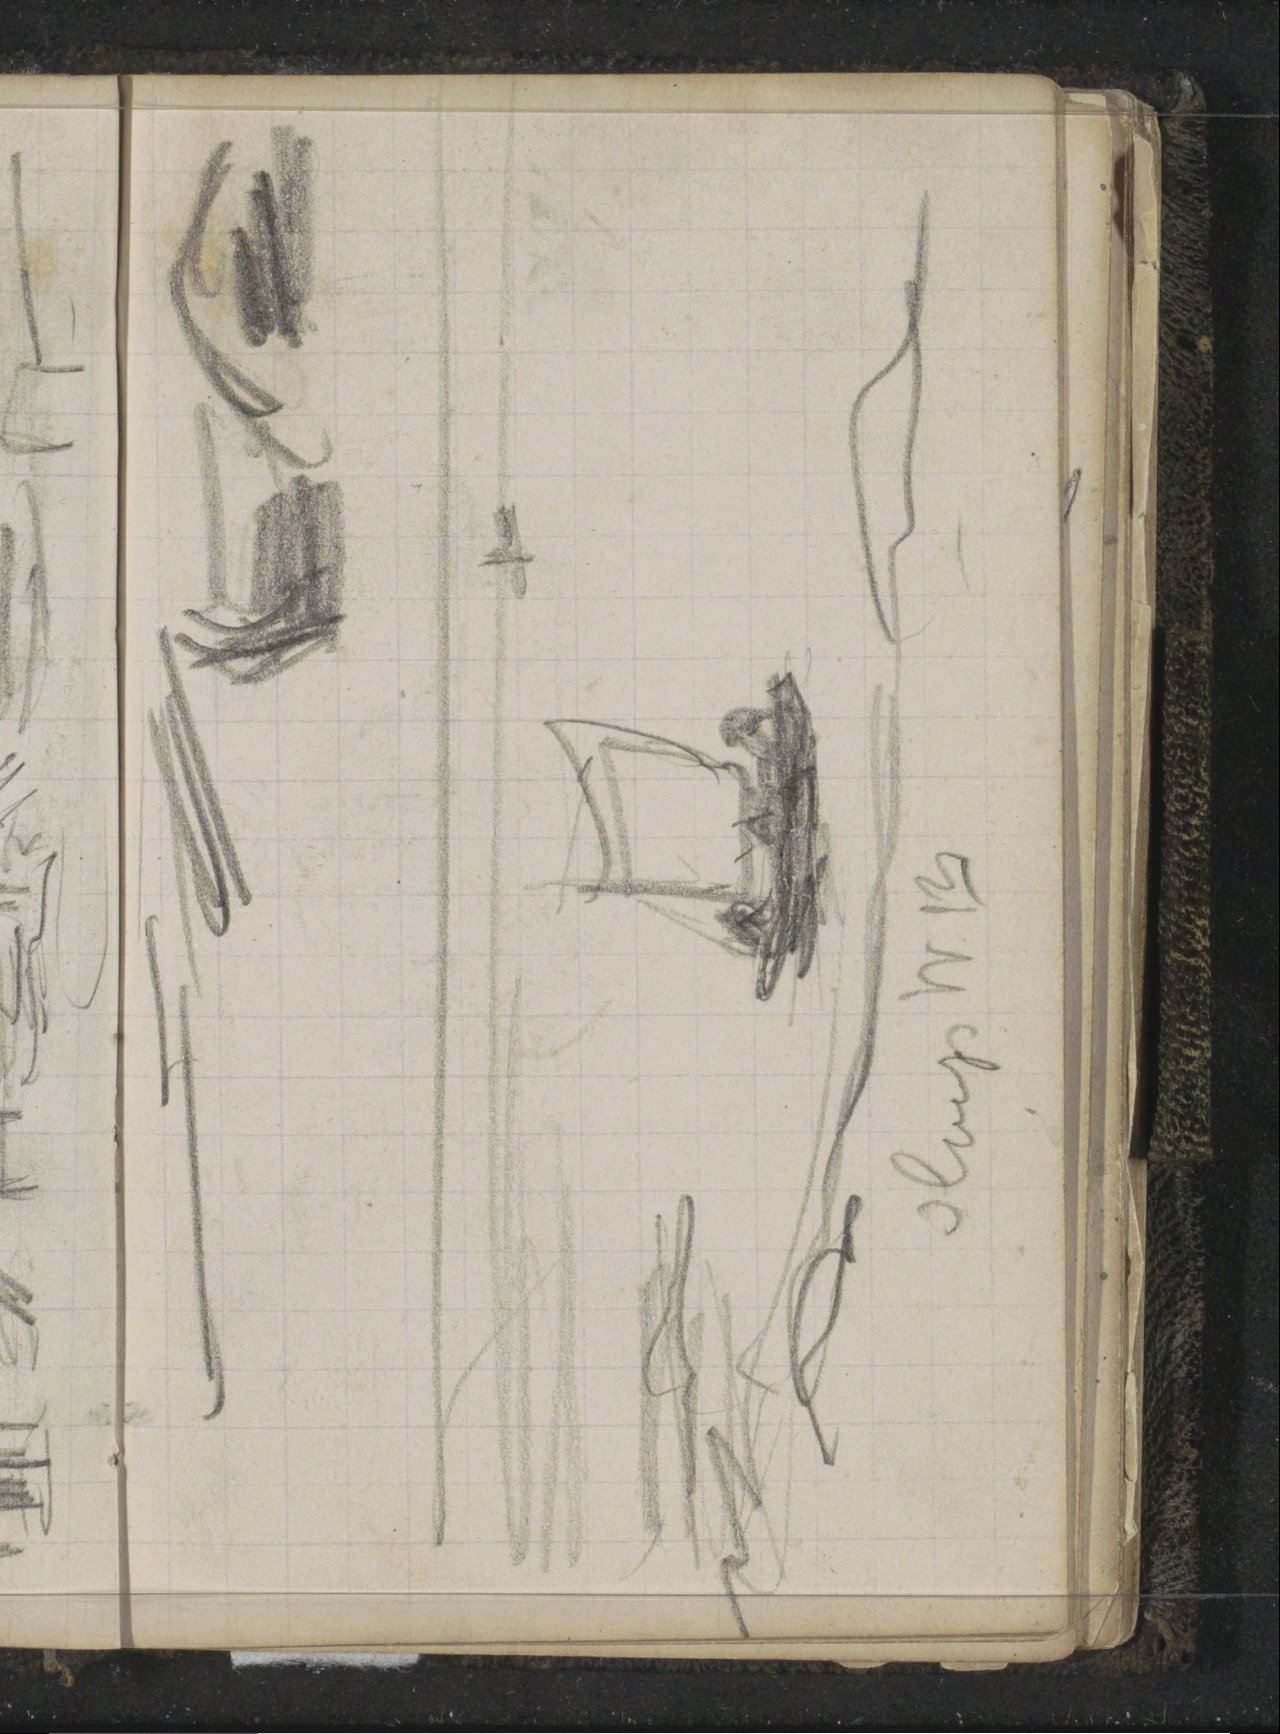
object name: sketchbook leaf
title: Sloep van de Willem Barentsz voor de kust van Nova Zembla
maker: louis apol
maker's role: draughtsman, painter, print maker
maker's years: 1850-1936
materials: pencil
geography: novaya zemlya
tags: sailing-ship, sailing-boat, coast (in polar regions)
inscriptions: annotation: ‘Sloep WB’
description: Blad 76 recto uit een schetsboek met 110 bladen betekend tijdens de expeditie naar Nova Zembla in 1880.